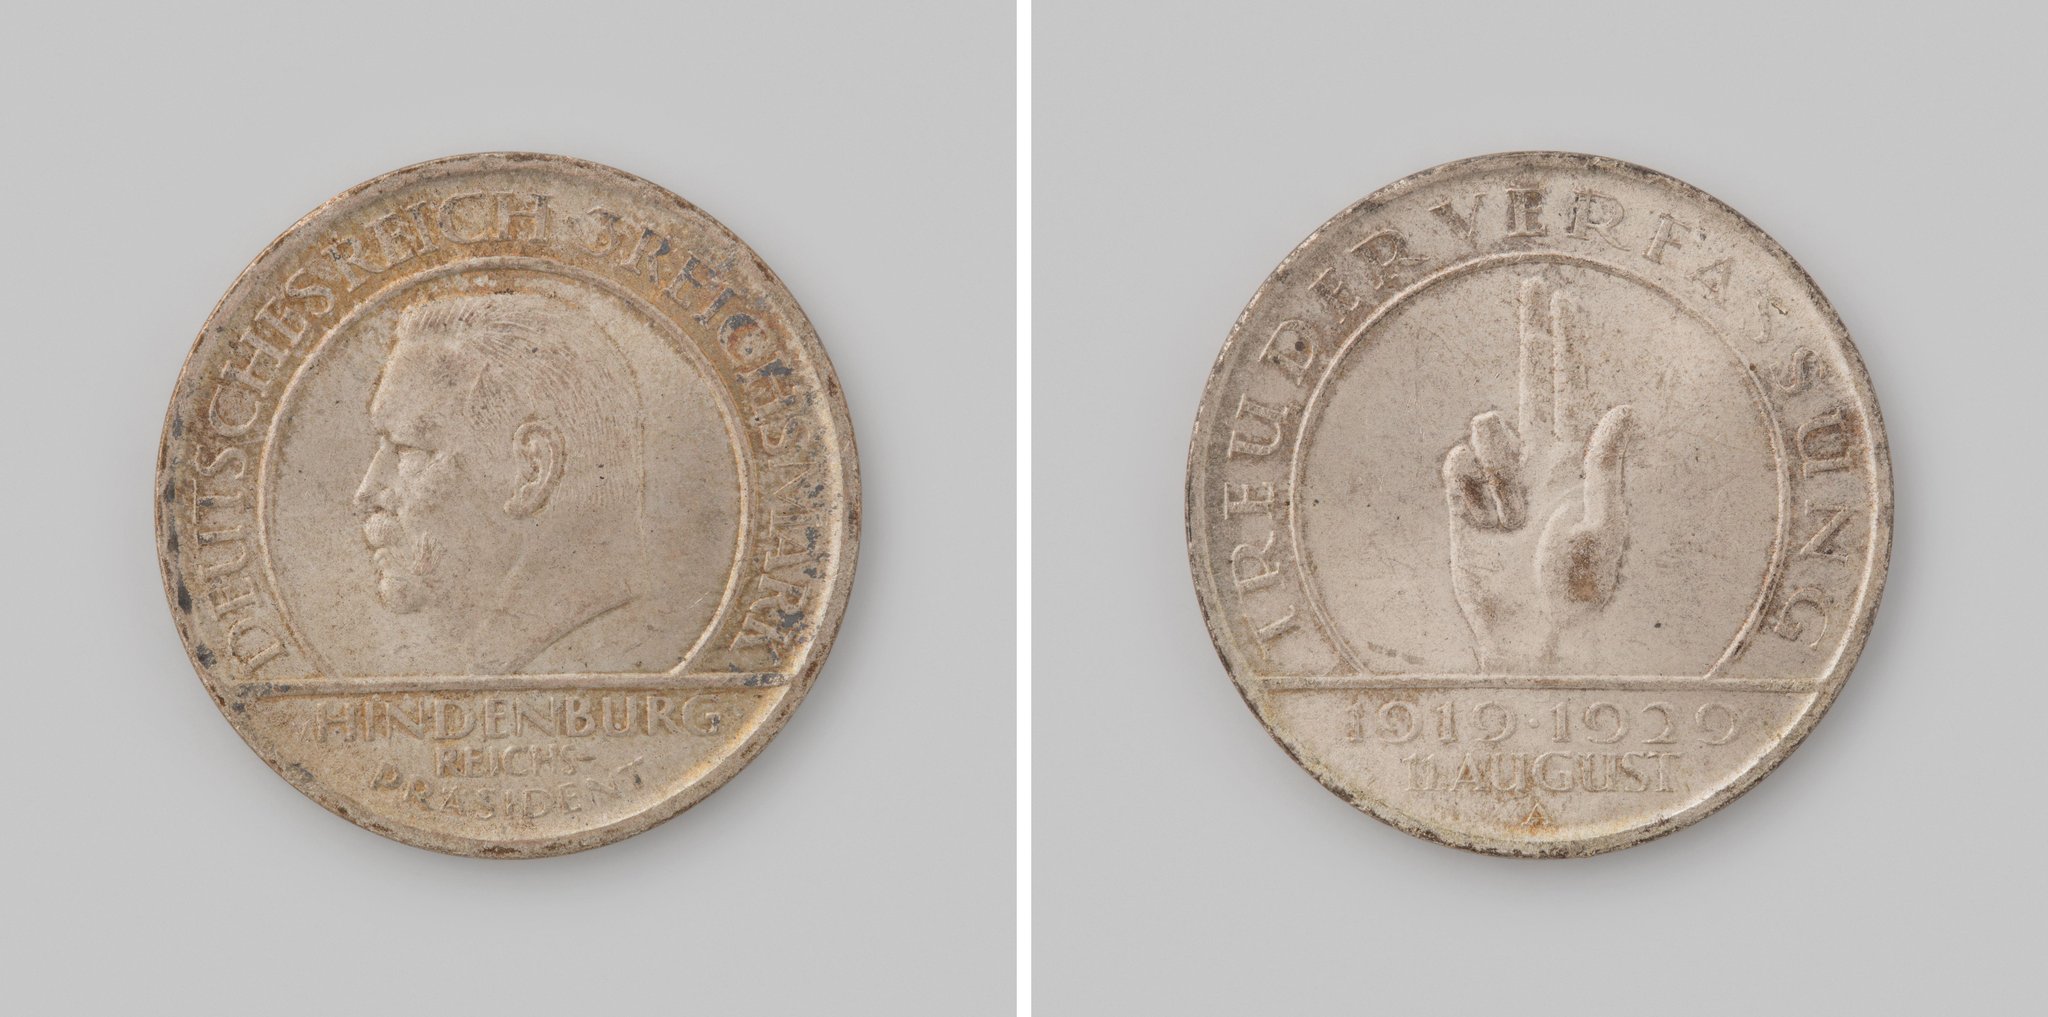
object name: coin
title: Duitsland, 3 Reichsmark, 1929 A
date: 1929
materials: silver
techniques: striking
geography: berlin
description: Zilveren herdenkingsmunt van het 10-jarig bestaan van de Grondwet. Voorzijde: hoofd van Hindenburg naar links. Waarde-aanduiding in omschrift. Keerzijde: eed afleggende hand. In afsnede data 11. August 1919-1929. Daaronder letter A. Randschrift.